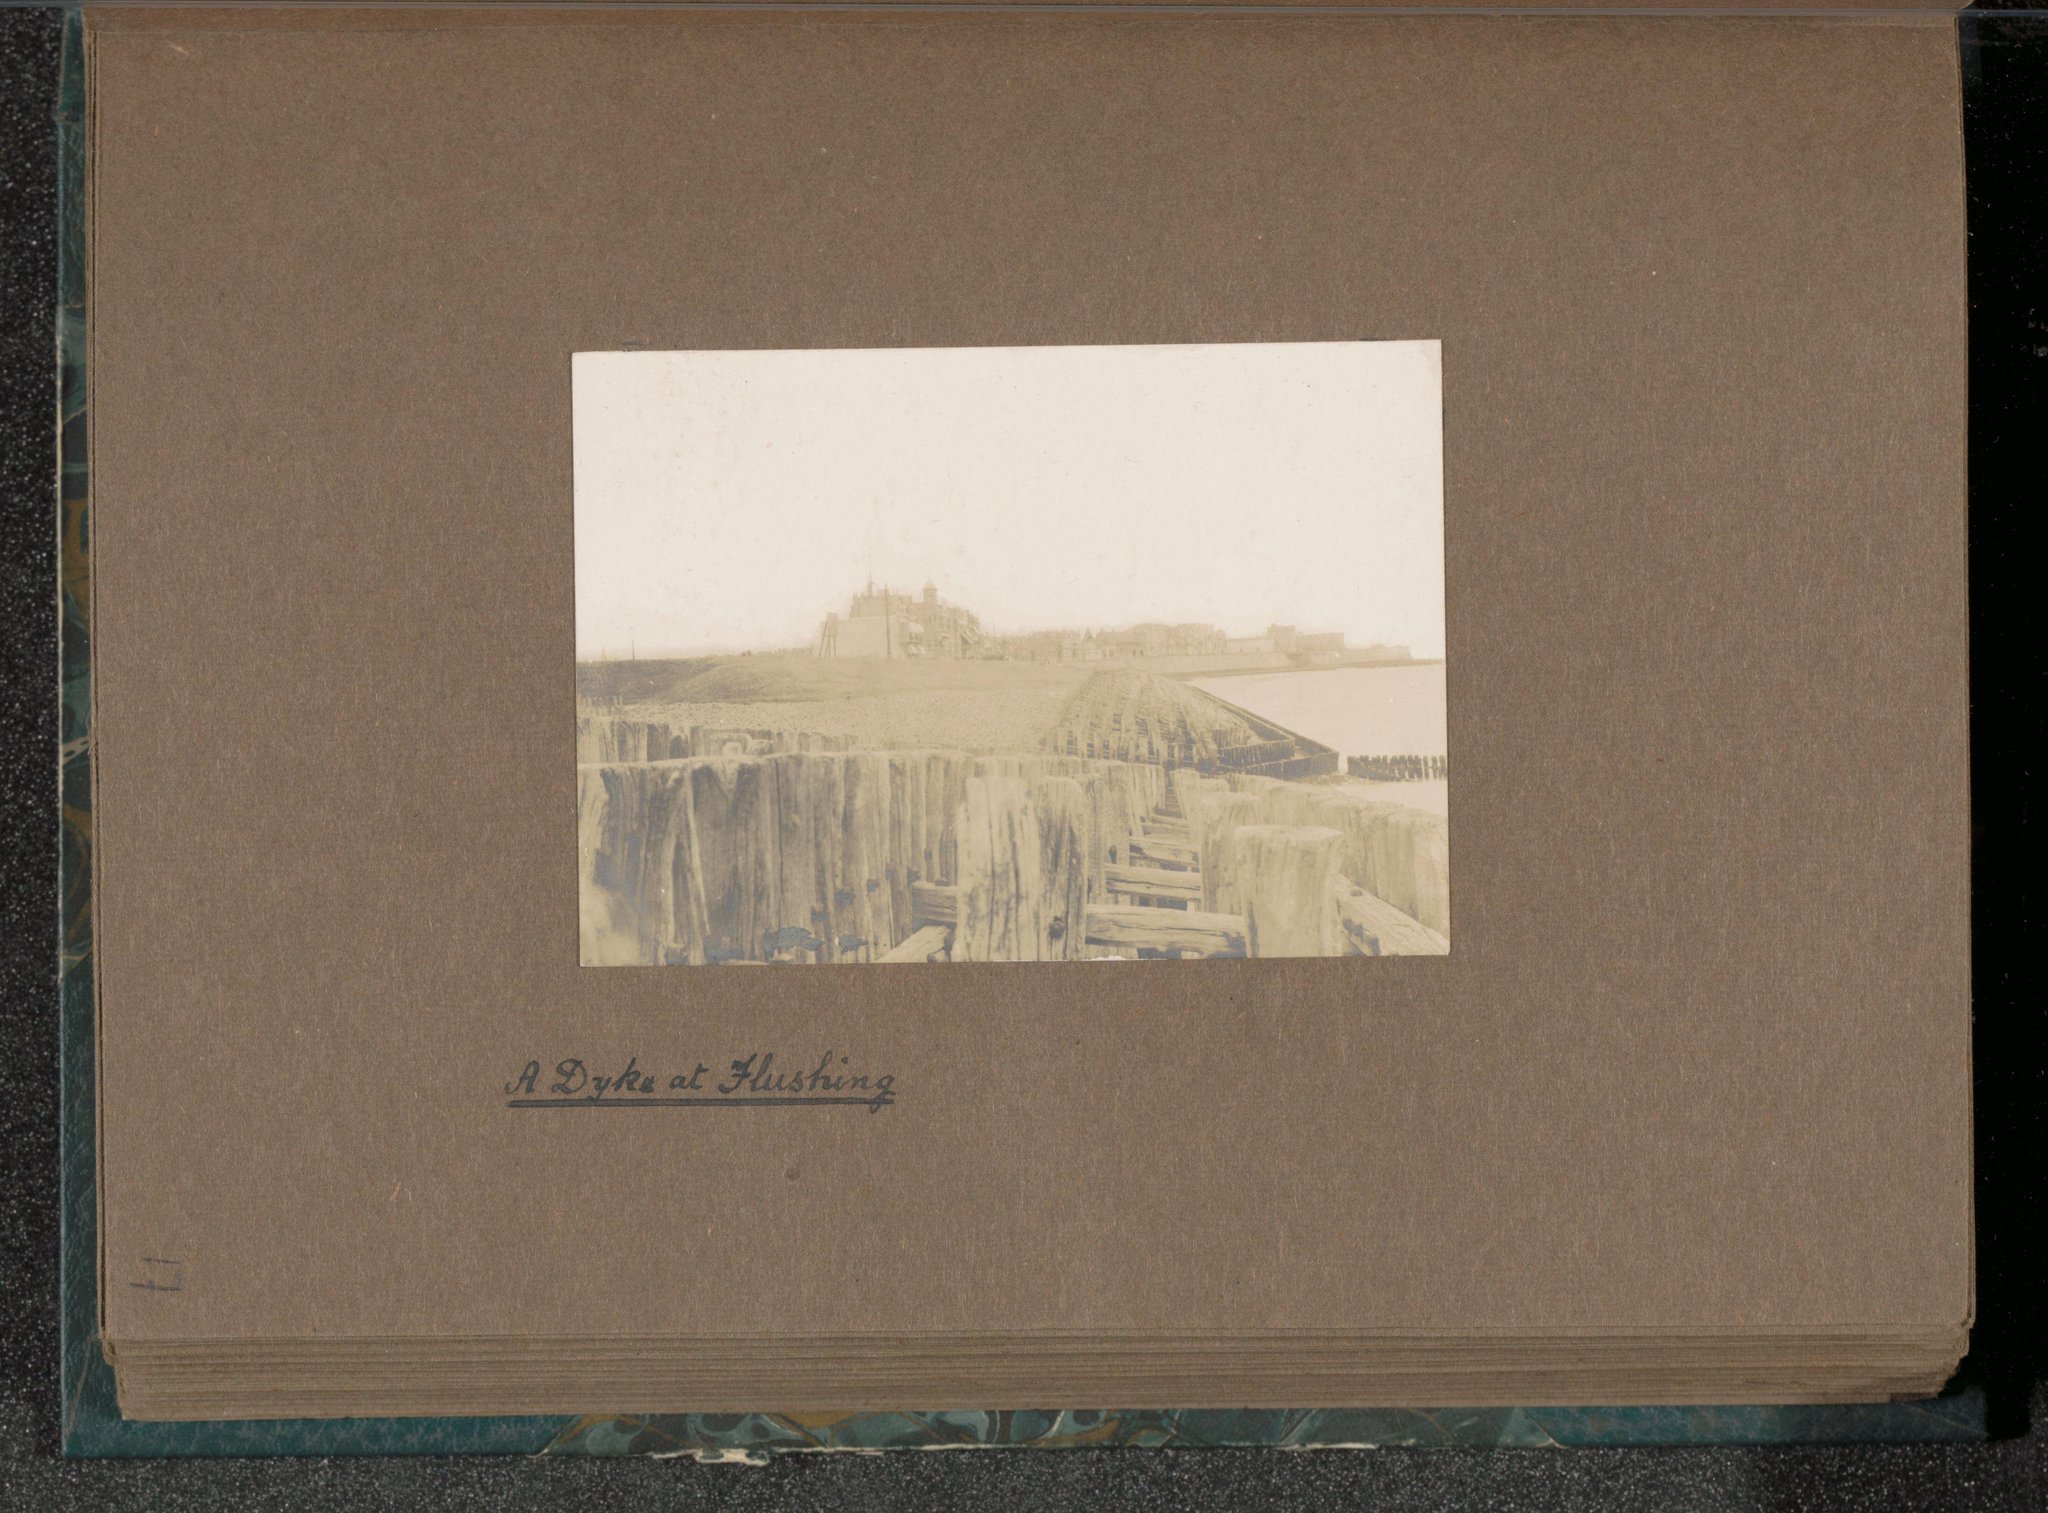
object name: photograph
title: Dijk en zeewering bij Vlissingen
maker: Anonymous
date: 1912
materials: photographic support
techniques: gelatin silver print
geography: flushing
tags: dikes, levee, coastal protection work, breakwater, travelling; tourism, flushing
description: Onderdeel van Fotoalbum van de excursie naar Nederland van de Britse amateurfotografenvereniging P.C.U.K.